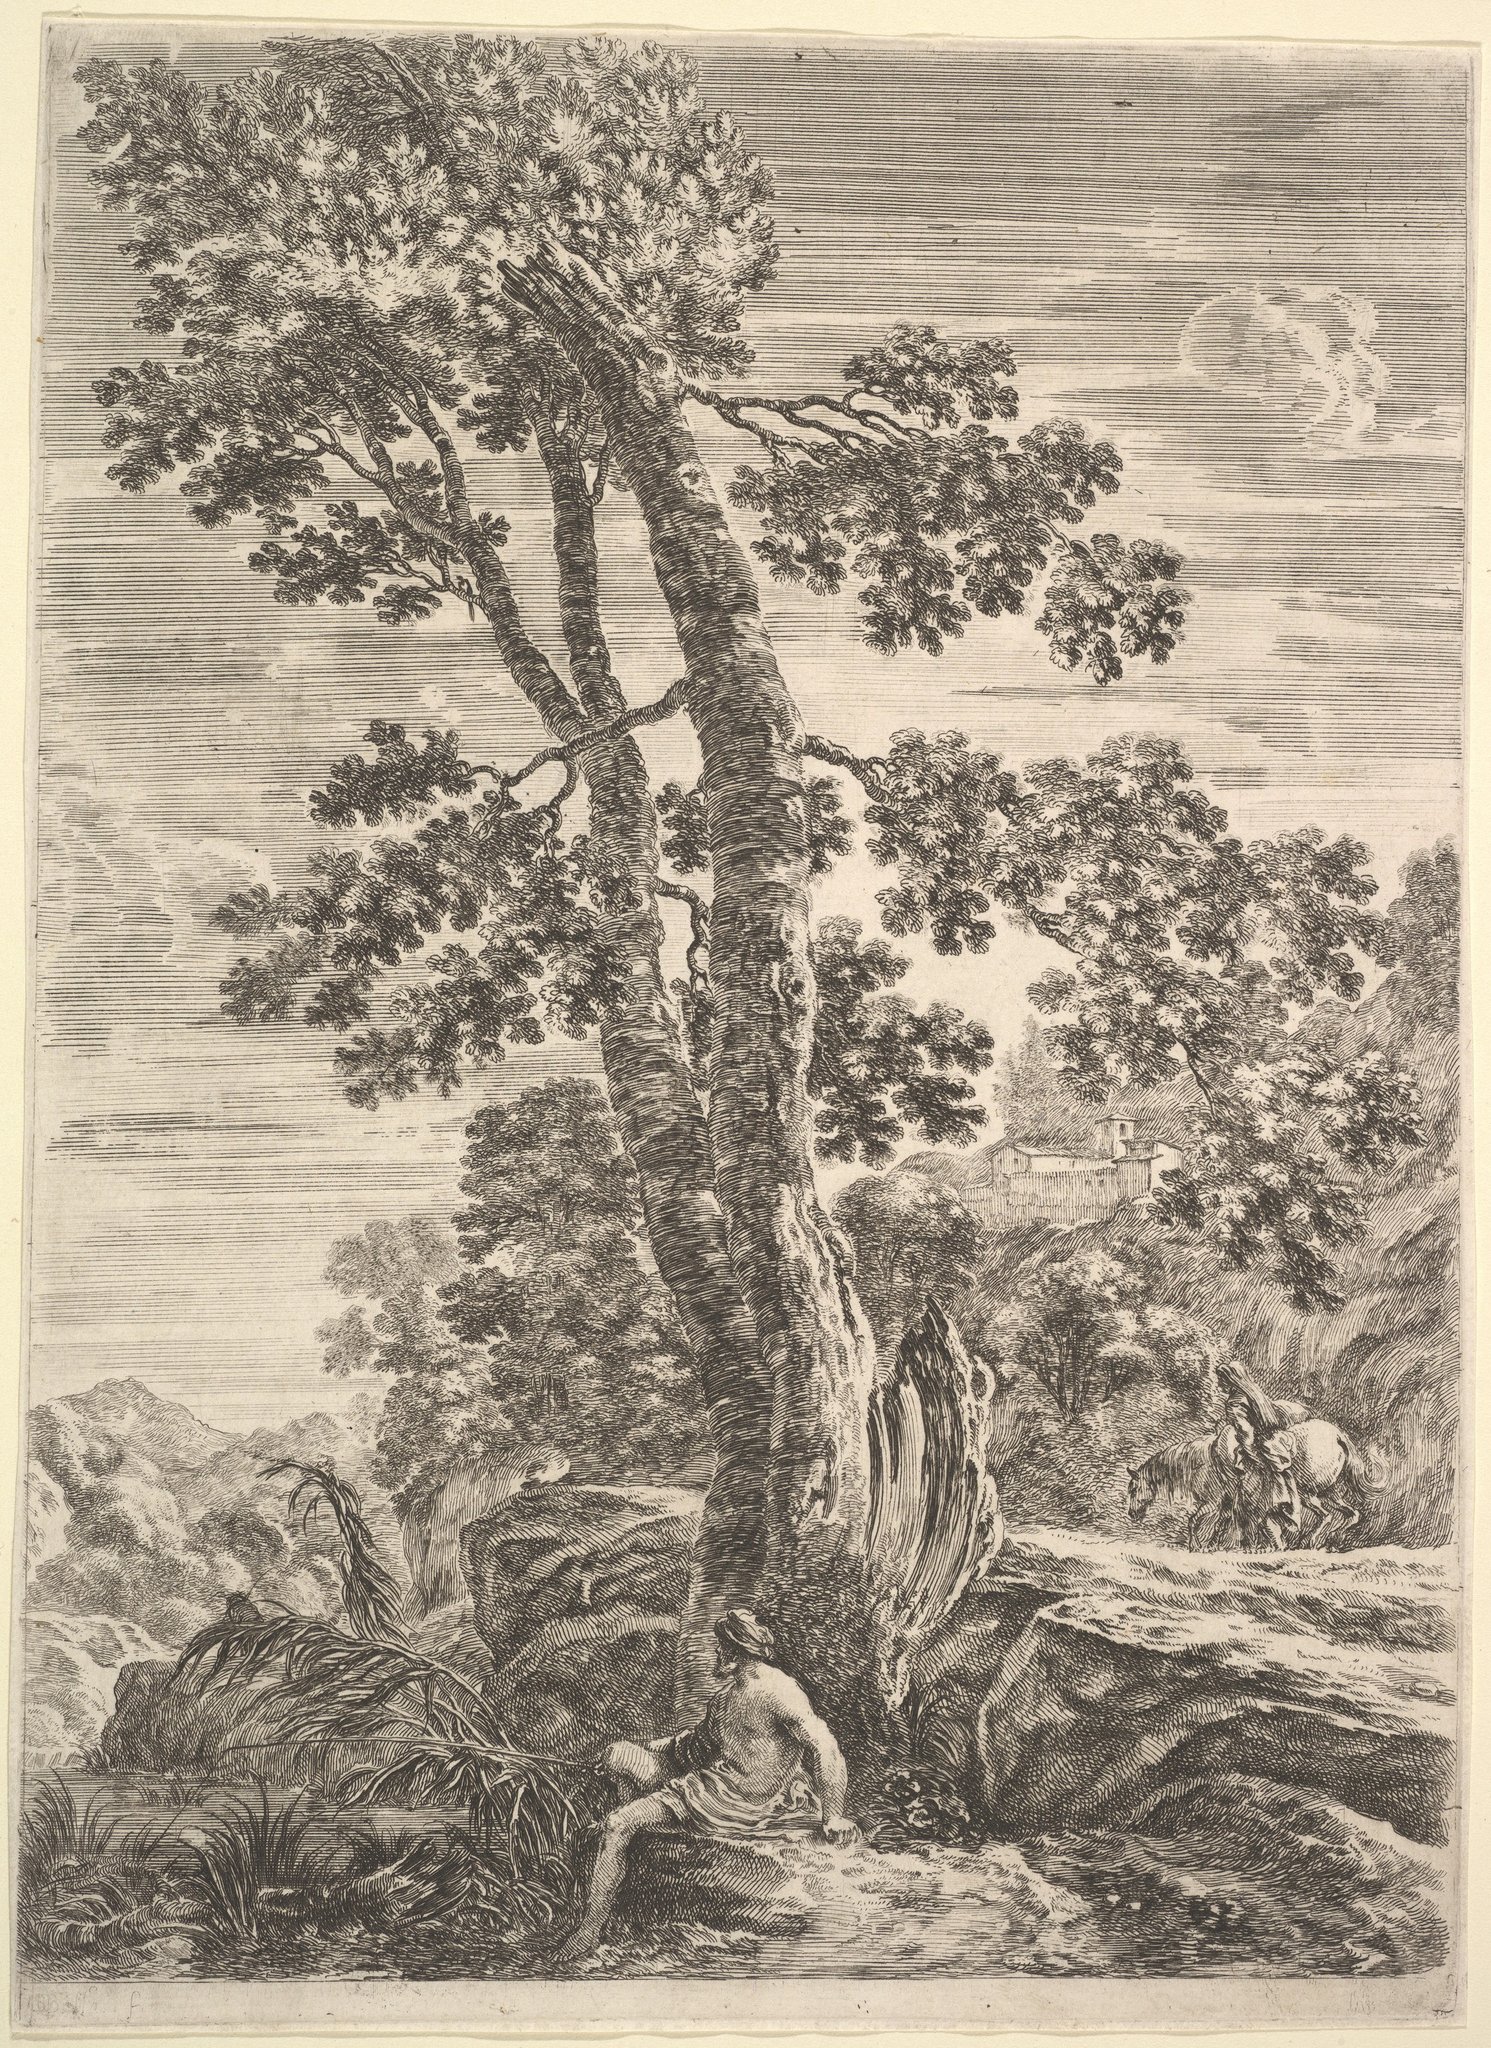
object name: print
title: A fisherman leaning against a large tree, a woman walking next to a horse in the background, from "Four large landscapes" (Quatre grands paysages en hauteur)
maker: stefano della bella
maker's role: artist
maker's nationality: italian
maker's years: 1610-1664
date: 1652-1657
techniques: etching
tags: men,women,horses,landscapes,trees